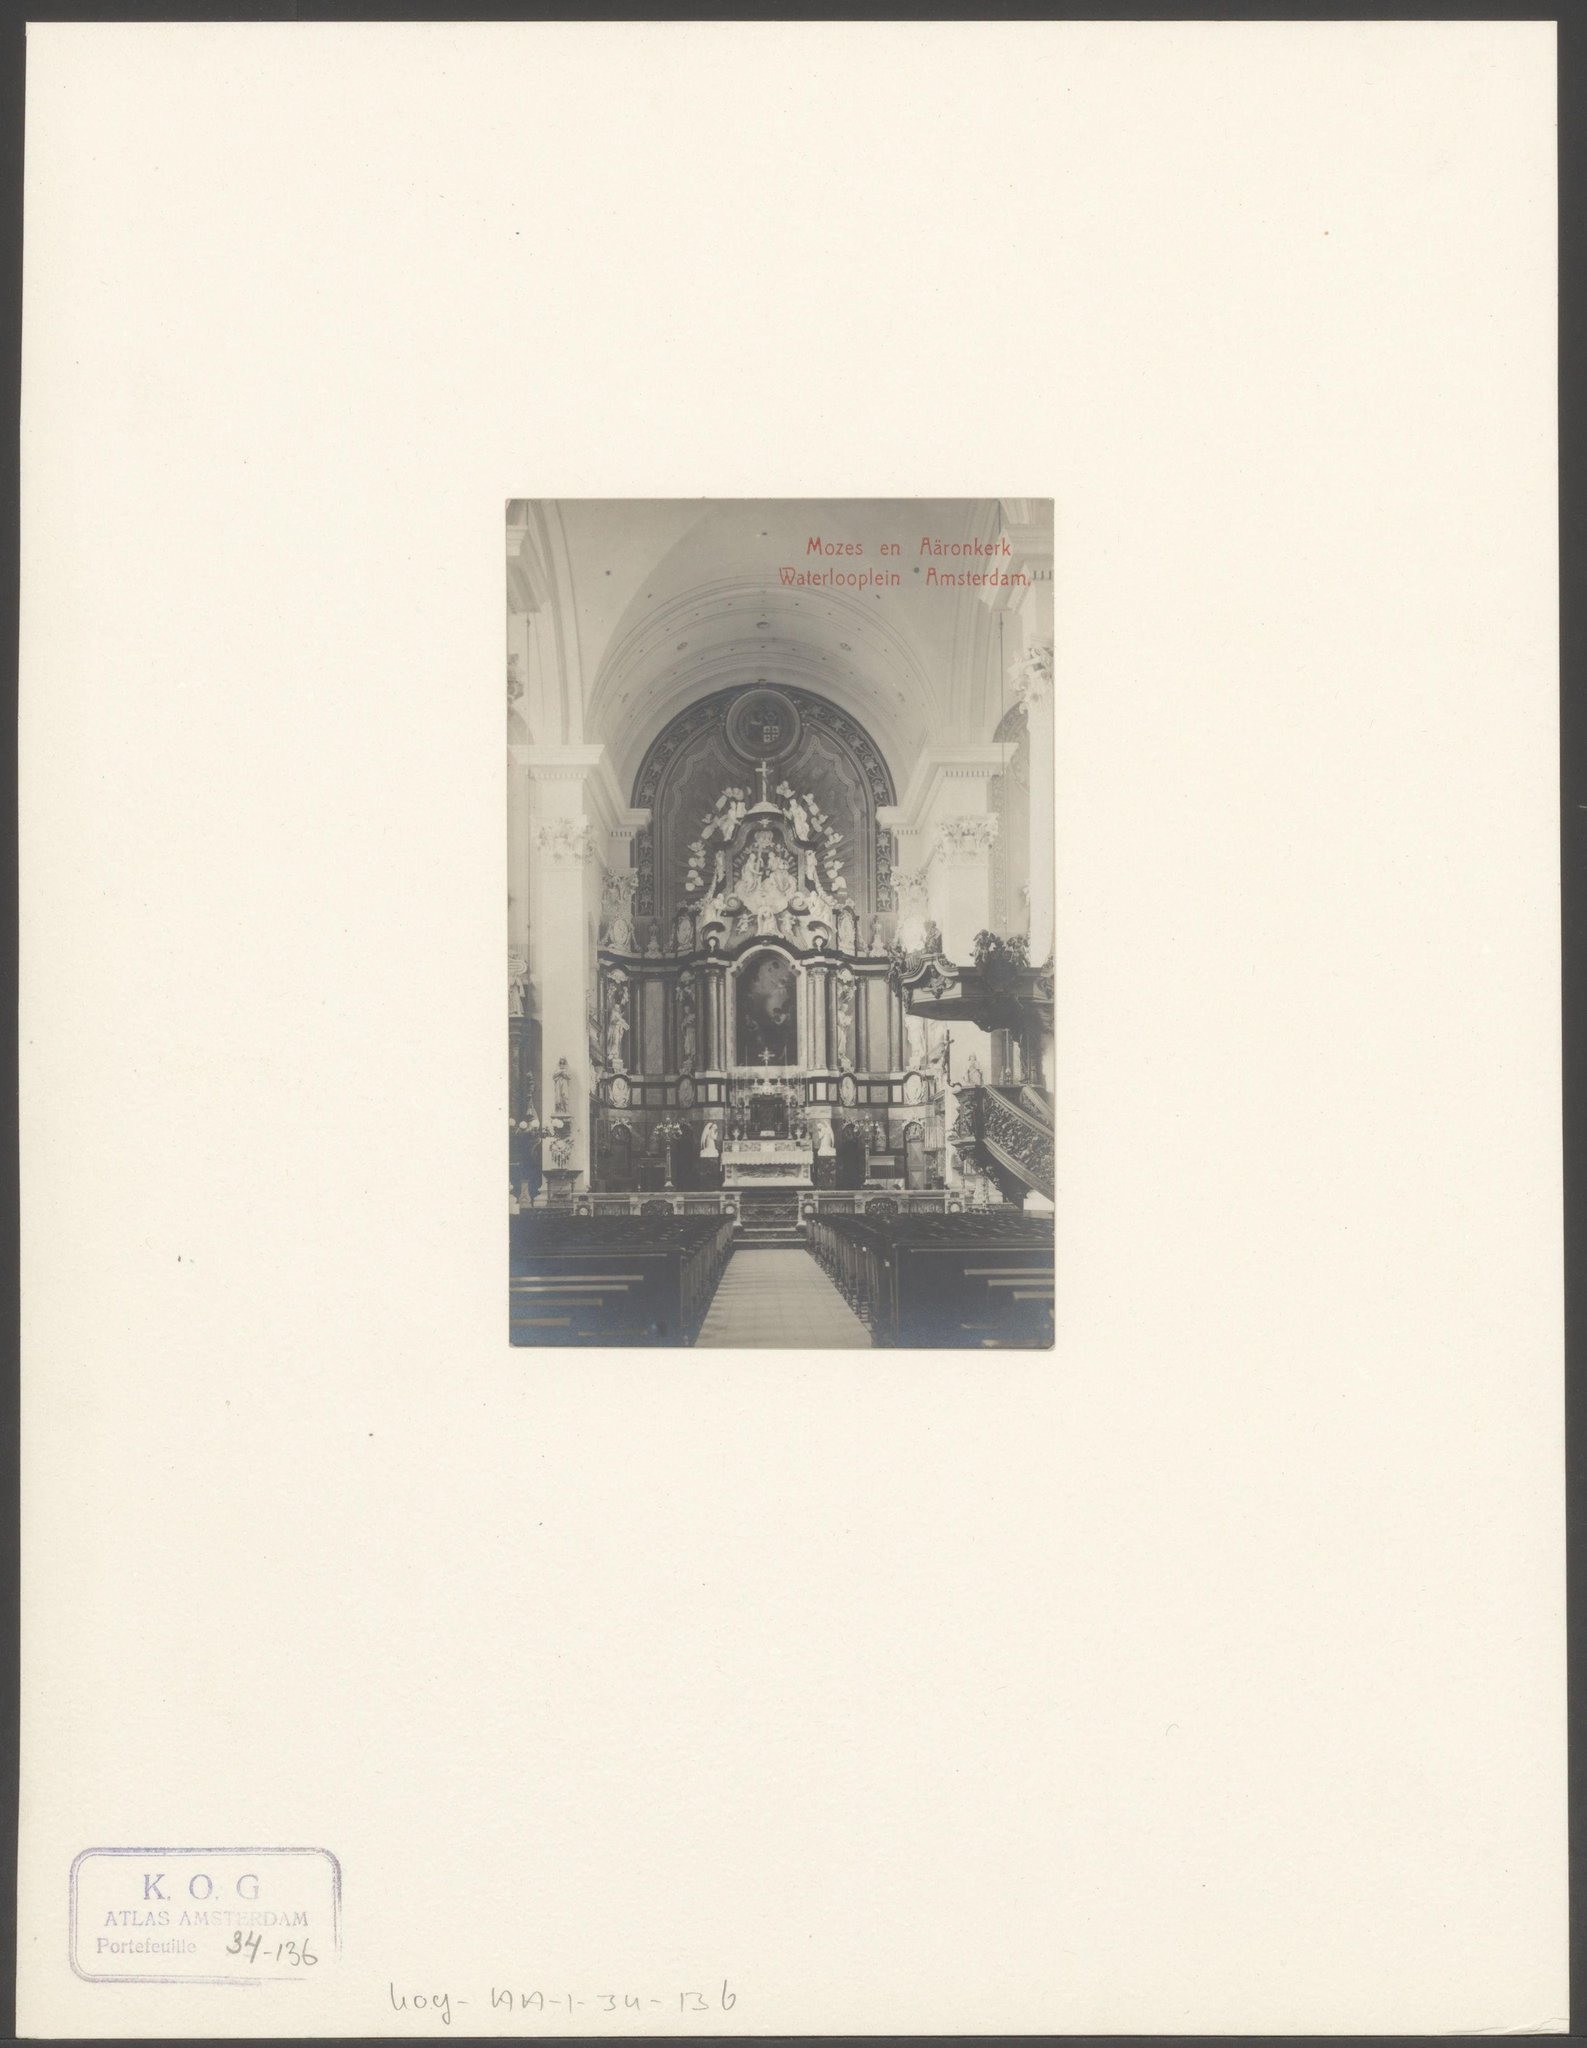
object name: ansichtkaart, prentbriefkaart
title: Mozes en Aäronkerk Waterlooplein Amsterdam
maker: Anonymous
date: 1905-1930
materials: paper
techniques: gelatin silver print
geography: amsterdam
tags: interior of church, altar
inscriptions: collector's mark: Lugt 1641b, collector's mark: Lugt 1641b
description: Onderwerpsrubriek binnen de Atlas Amsterdam: Kerkwezen: R.K. Gemeenten: Begijnhof t/m Petrus en Paulus.